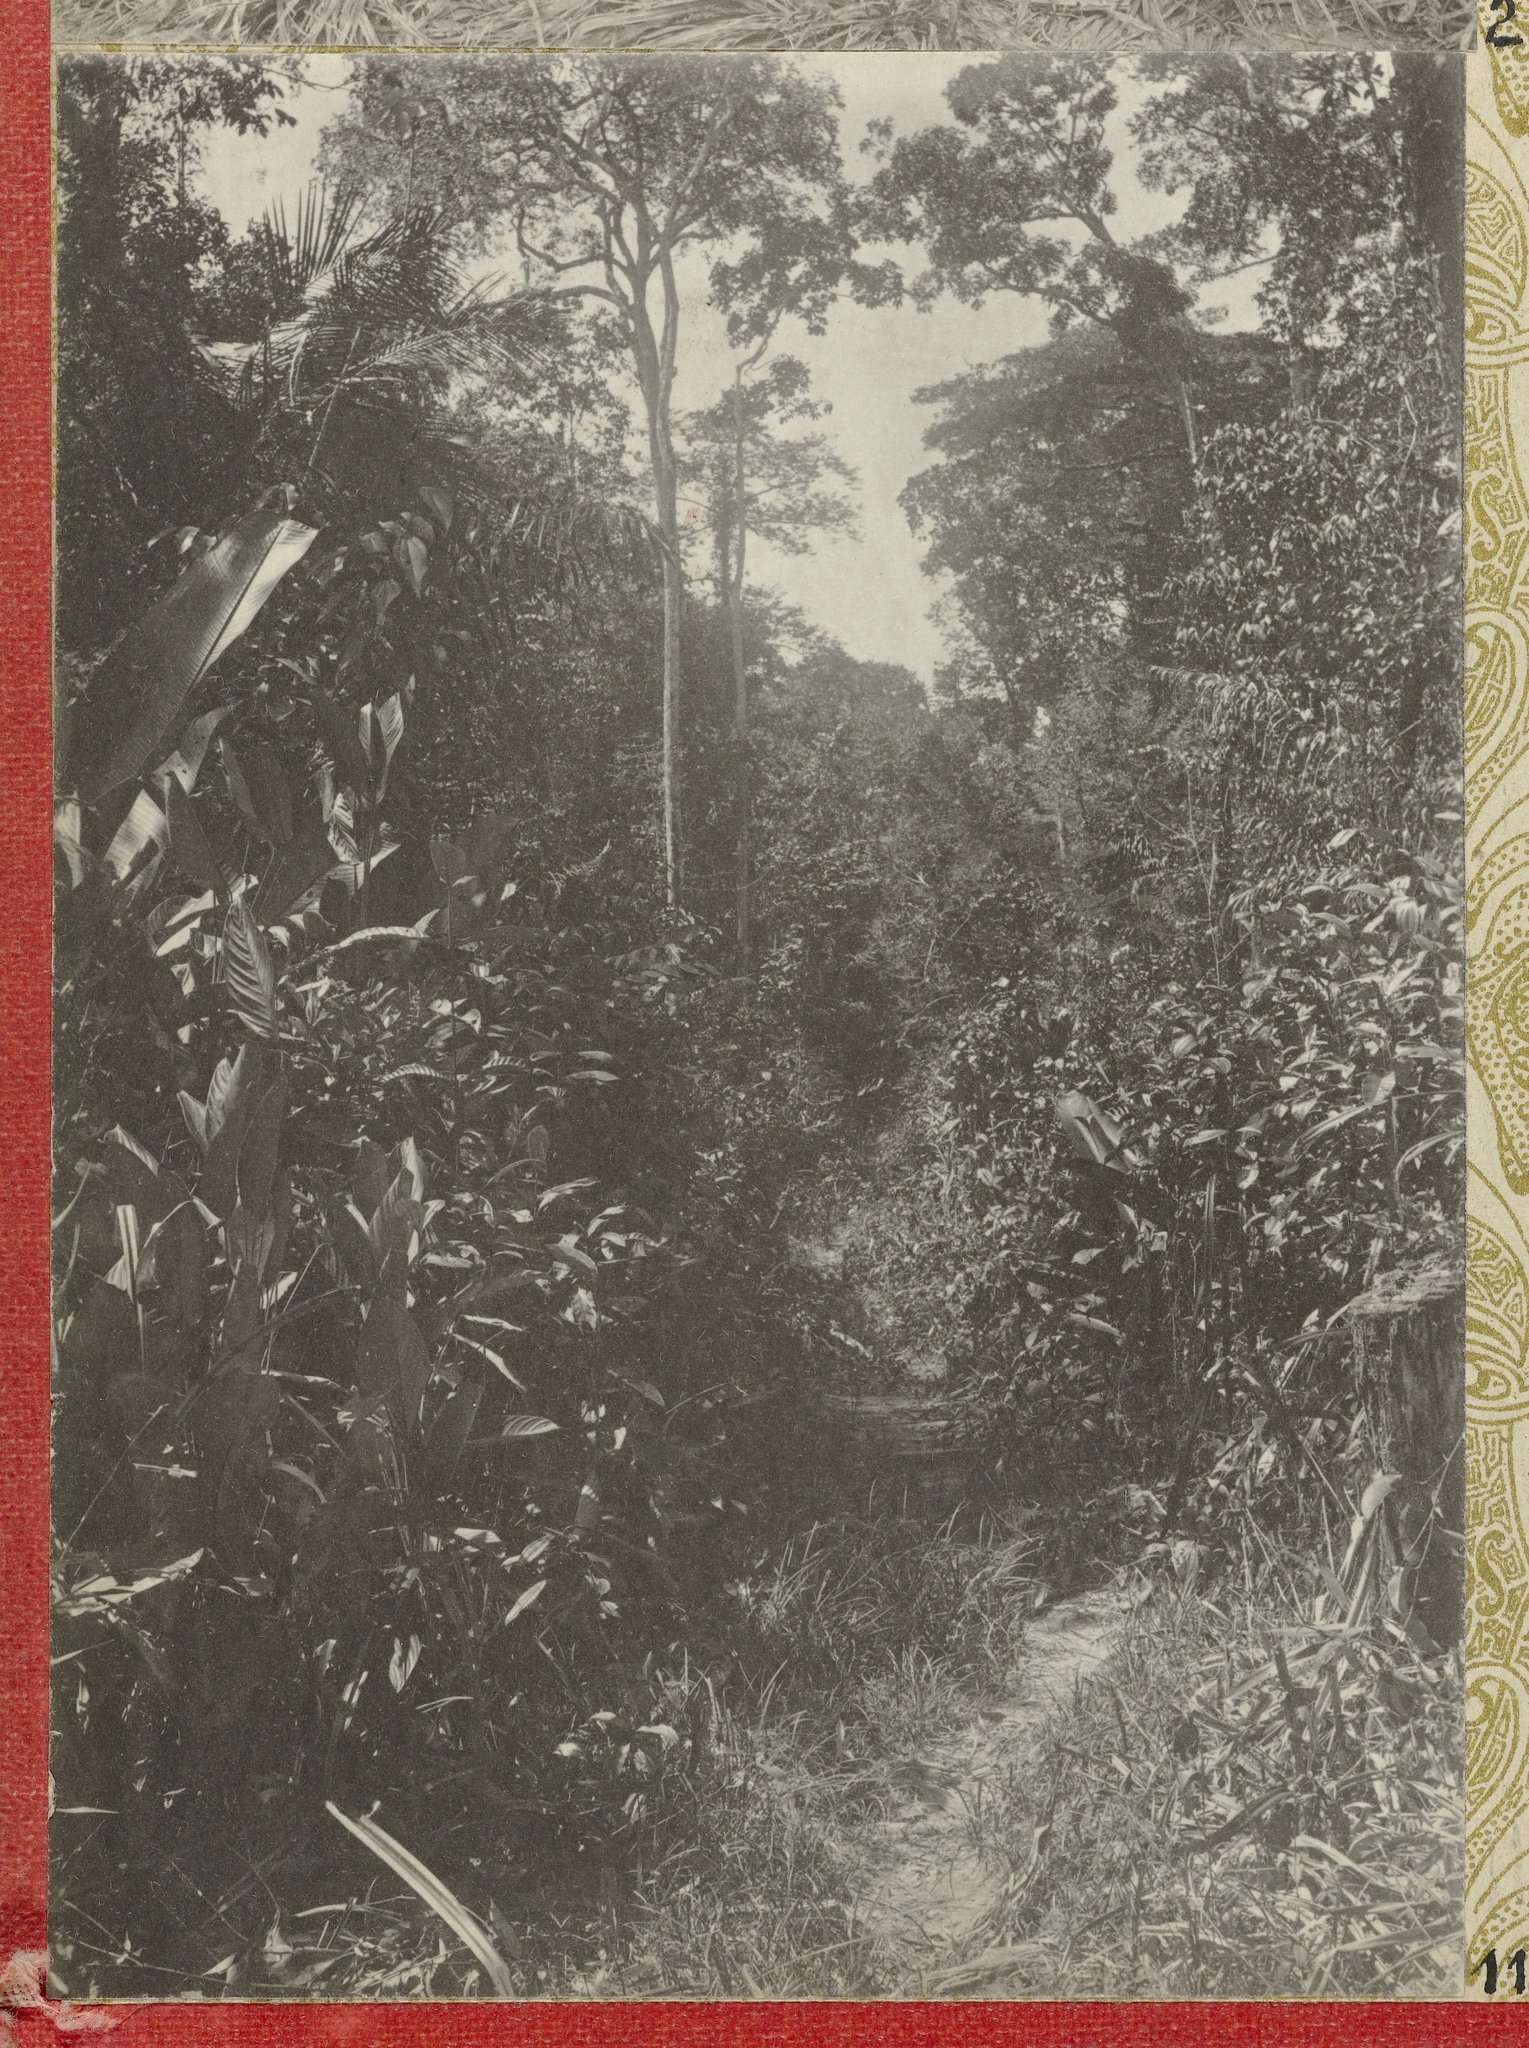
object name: photograph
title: Pad door het bos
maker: hendrik doijer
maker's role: engineer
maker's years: 1863-1925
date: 1903-1910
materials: photographic support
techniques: gelatin silver print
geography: suriname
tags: suriname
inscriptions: inscription: ‘11’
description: Een pad lopend door het bos. Onderdeel van het fotoalbum Souvenir de Voyage (deel 2), over het leven van de familie Doijer in en rond de plantage Ma Retraite in Suriname in de jaren 1903-1910.